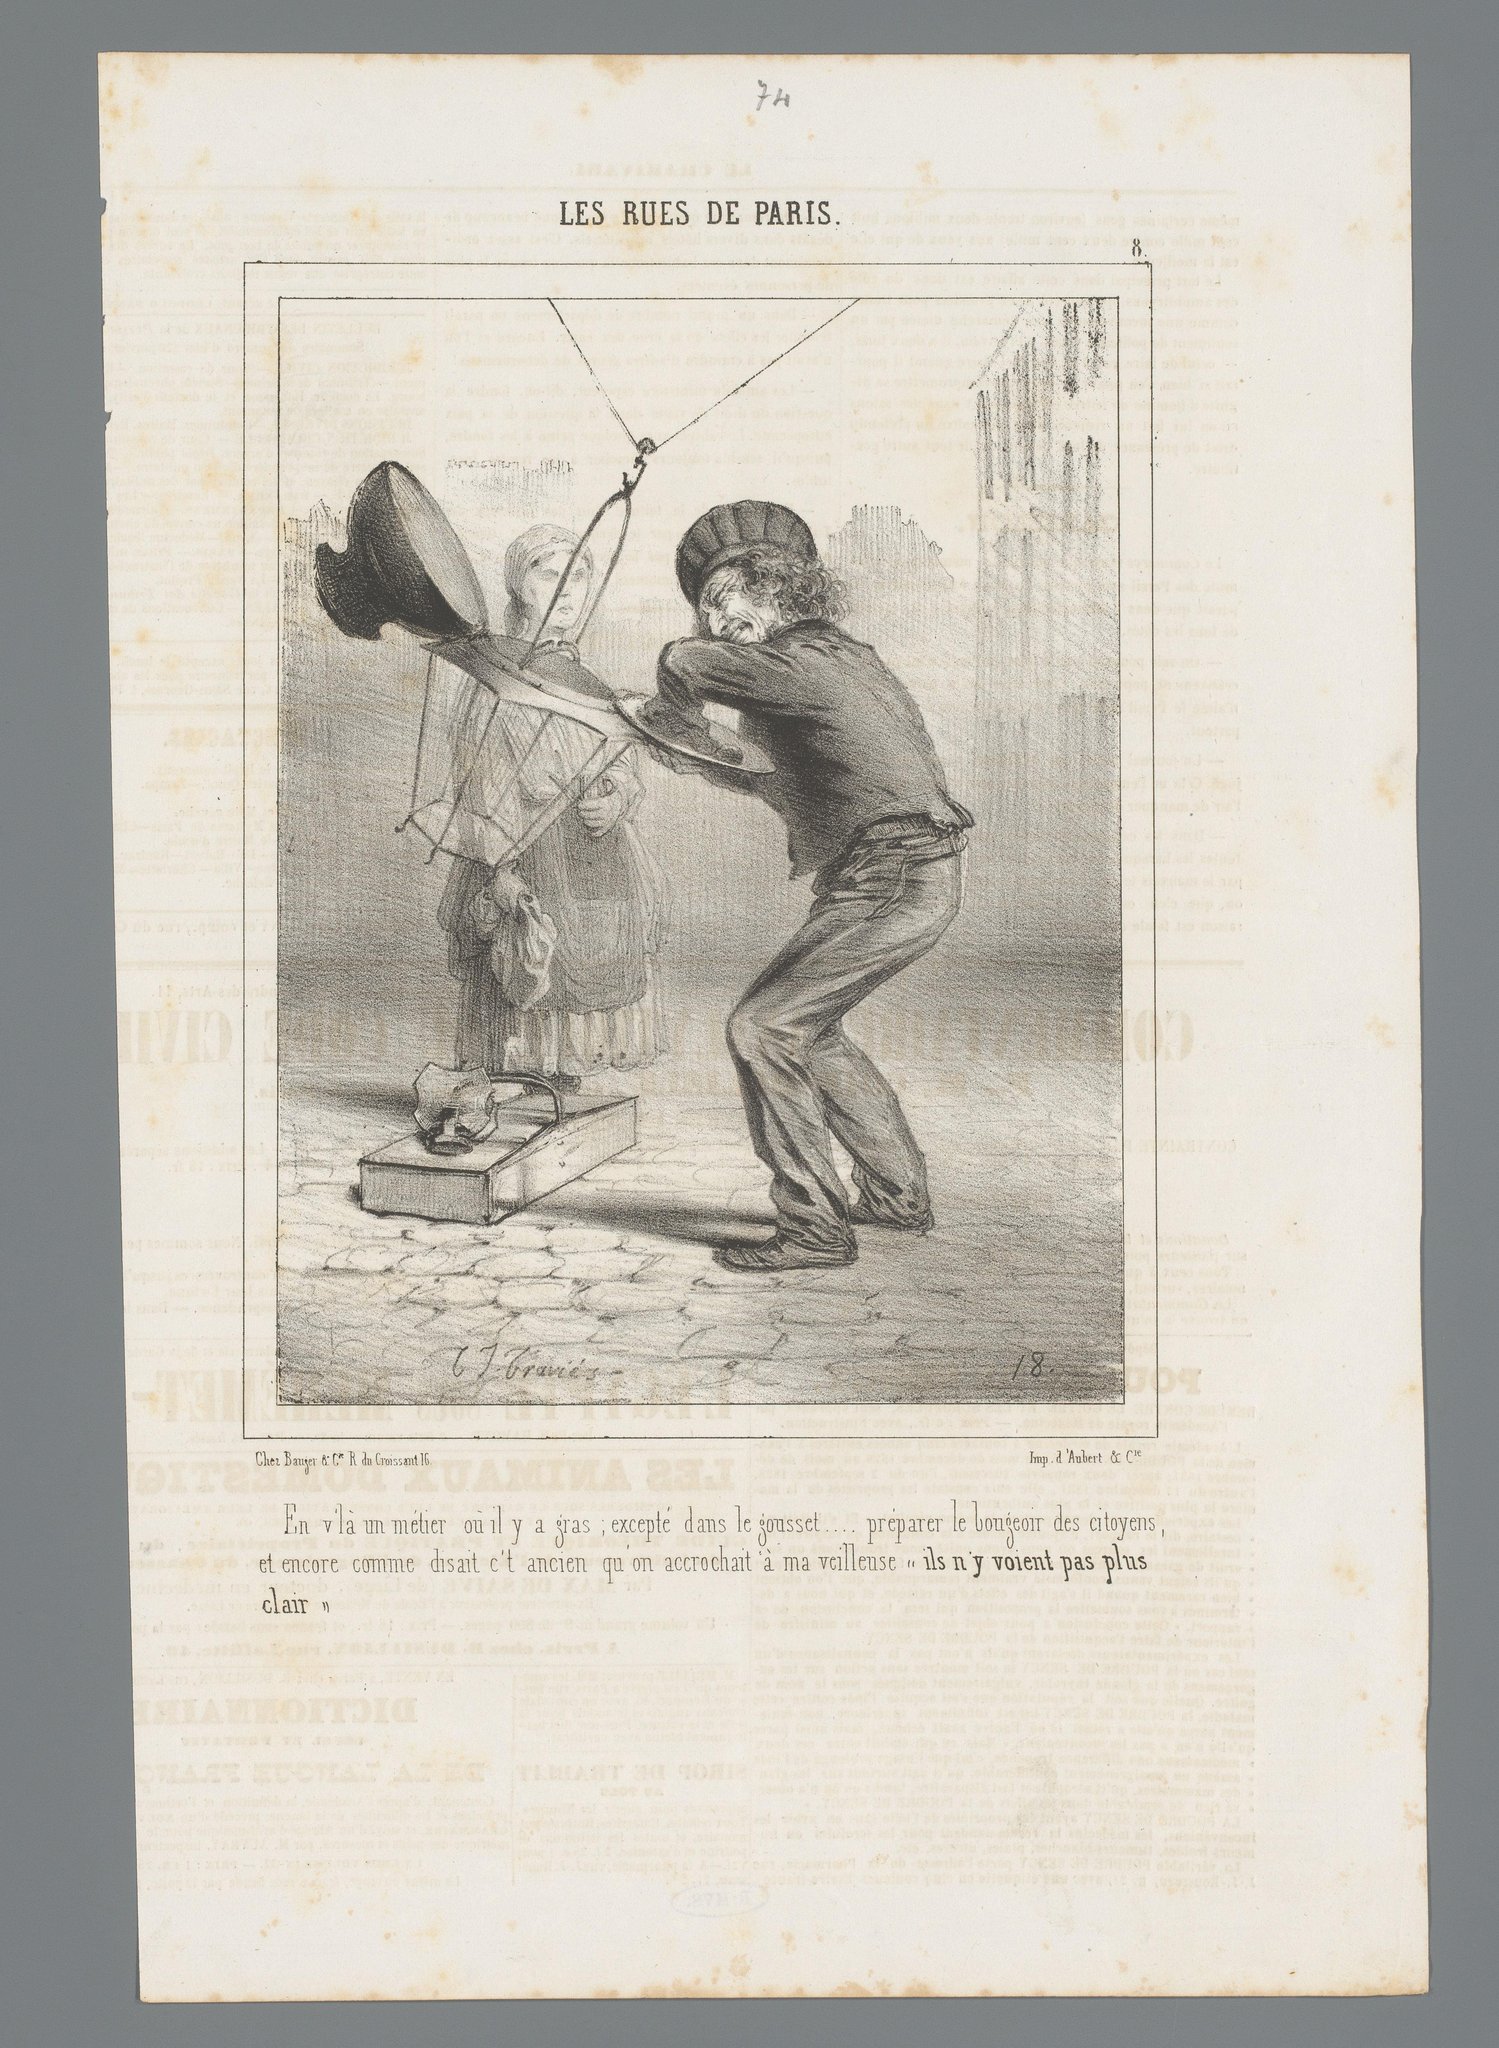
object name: cartoon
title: Les rues de Paris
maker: charles-joseph traviès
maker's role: print maker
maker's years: 1804-1859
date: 1843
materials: paper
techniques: letterpress printing, lithograph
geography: paris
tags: adult man ( + one person), street lighting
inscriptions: collector's mark: Lugt 2228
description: Prent uit: Le Charivari 12 (1843), nr. 21, 21 januari 1843.